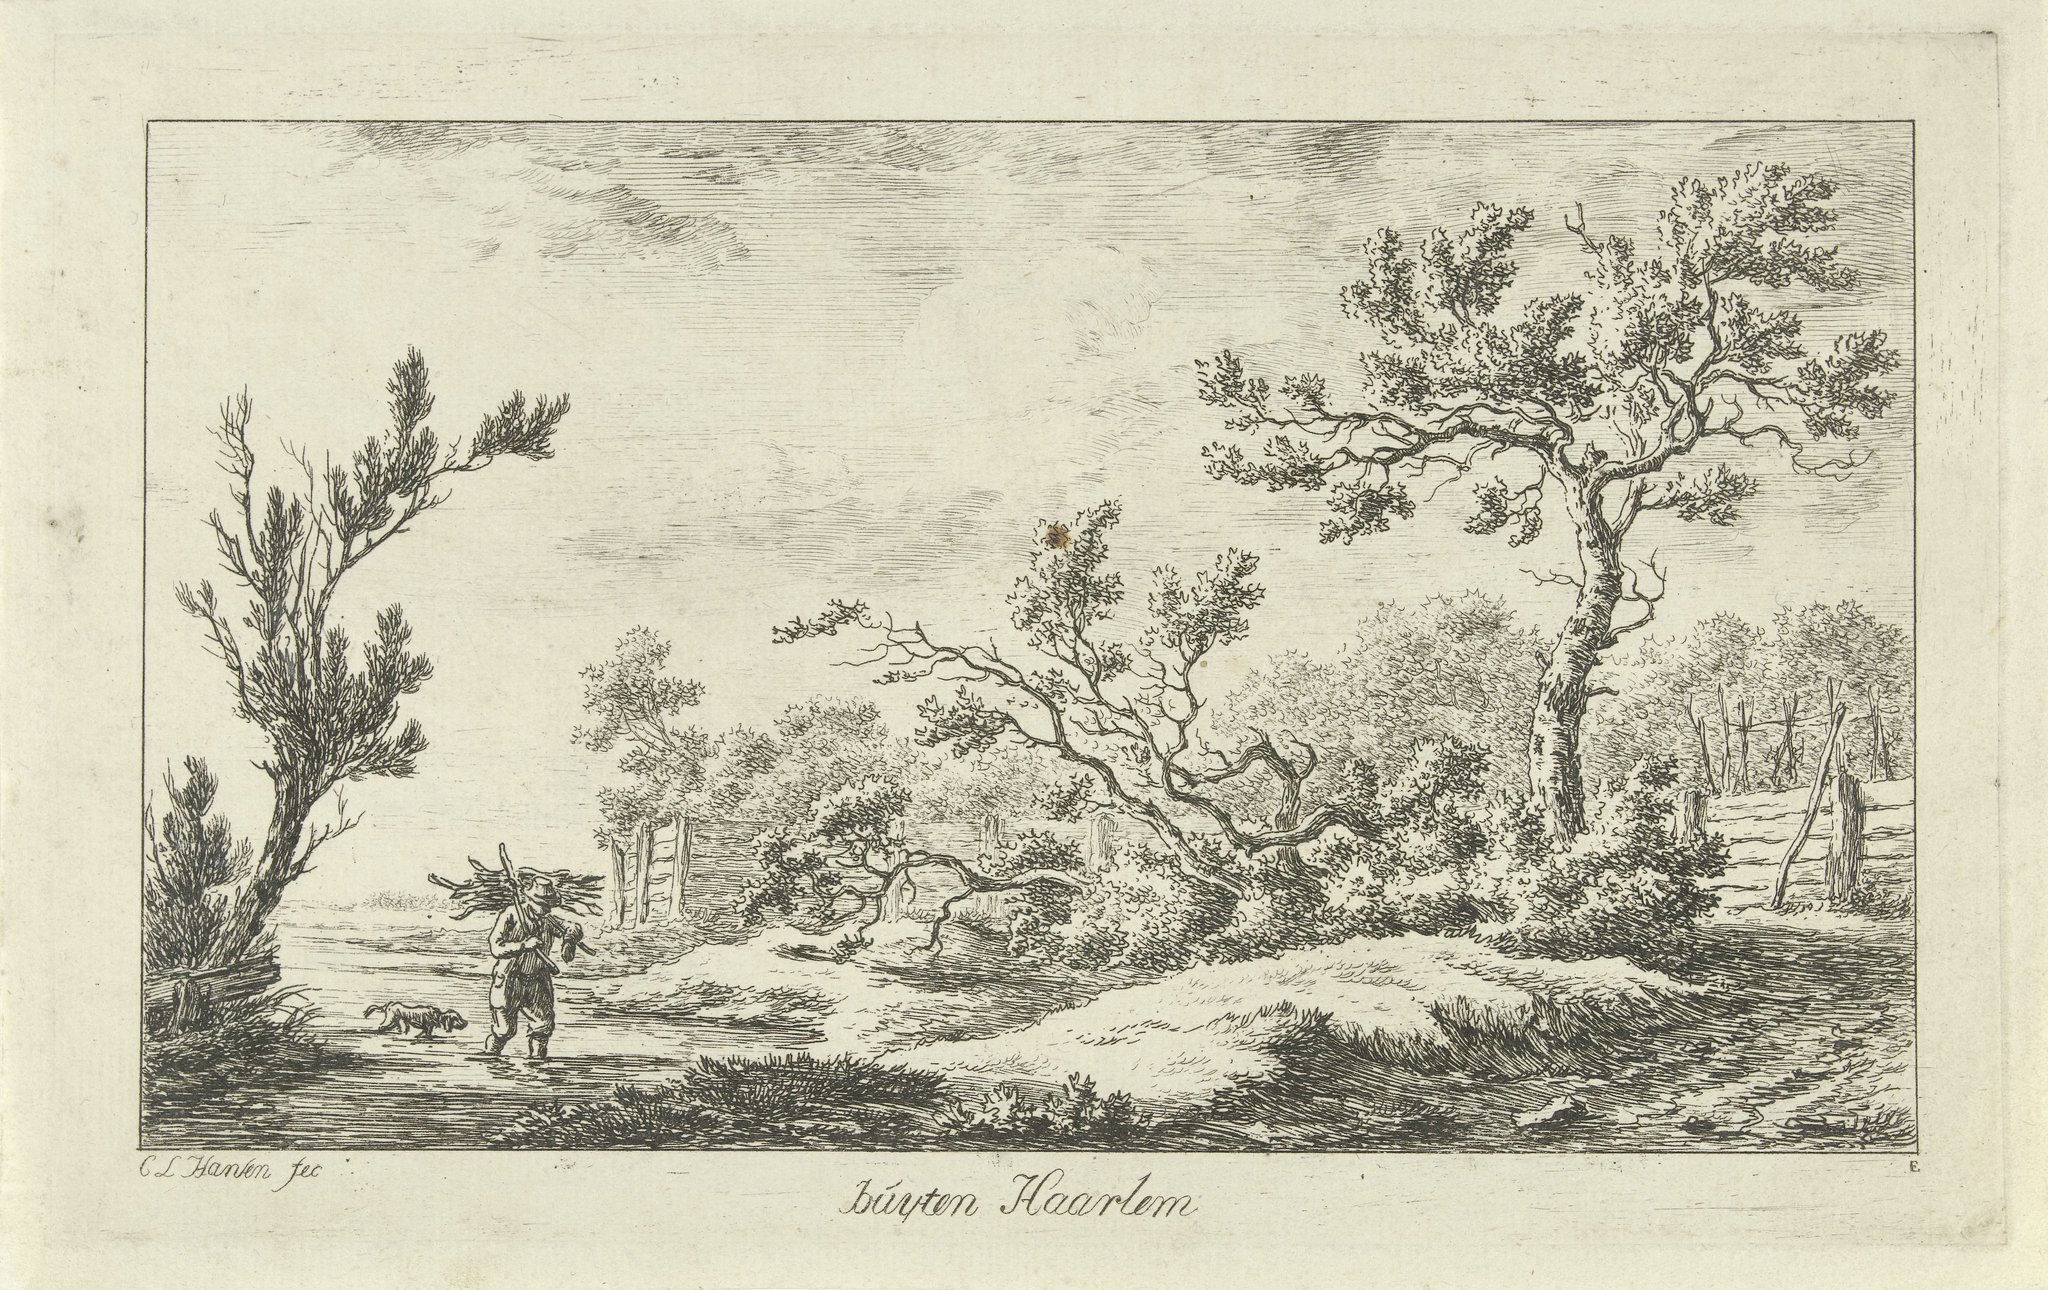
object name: print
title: Buyten Haarlem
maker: carel lodewijk hansen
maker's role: draughtsman, painter, print maker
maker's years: 1765-1840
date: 1780-1840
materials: paper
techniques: etching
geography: netherlands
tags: river bank, dog, woodgathering, woodgatherer (+ outdoors; in the open air), haarlem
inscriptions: collector's mark: Lugt 2228